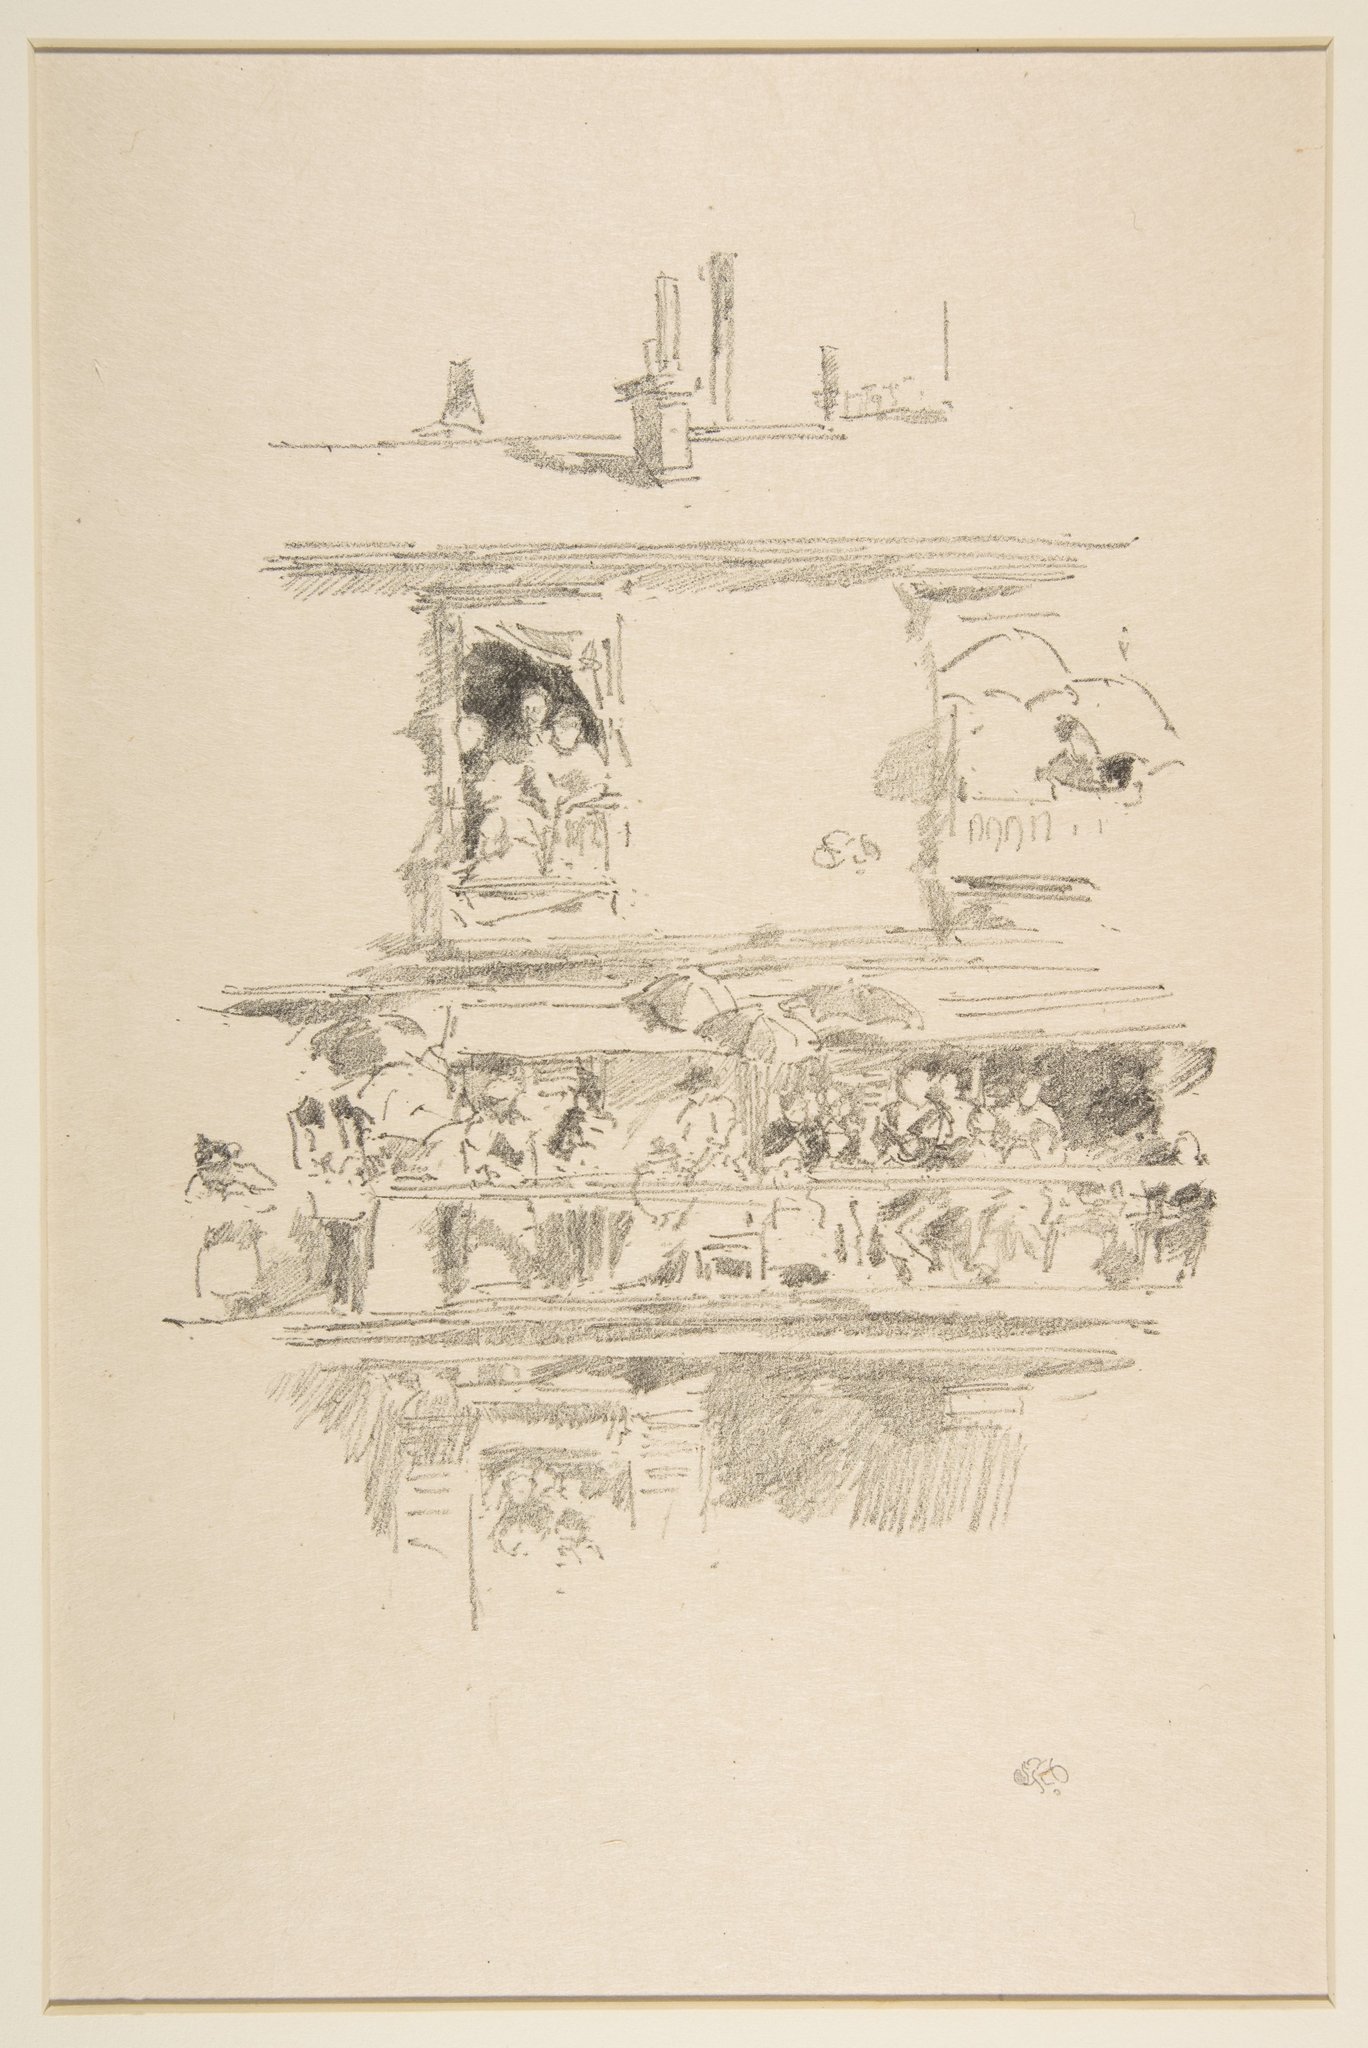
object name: print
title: The Long Balcony (Paris Windows, The Long Balcony)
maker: james mcneill whistler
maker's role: artist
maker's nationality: american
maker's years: 1834-1903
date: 1894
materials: ink, parchment, paper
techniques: printing, lithography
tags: balconies